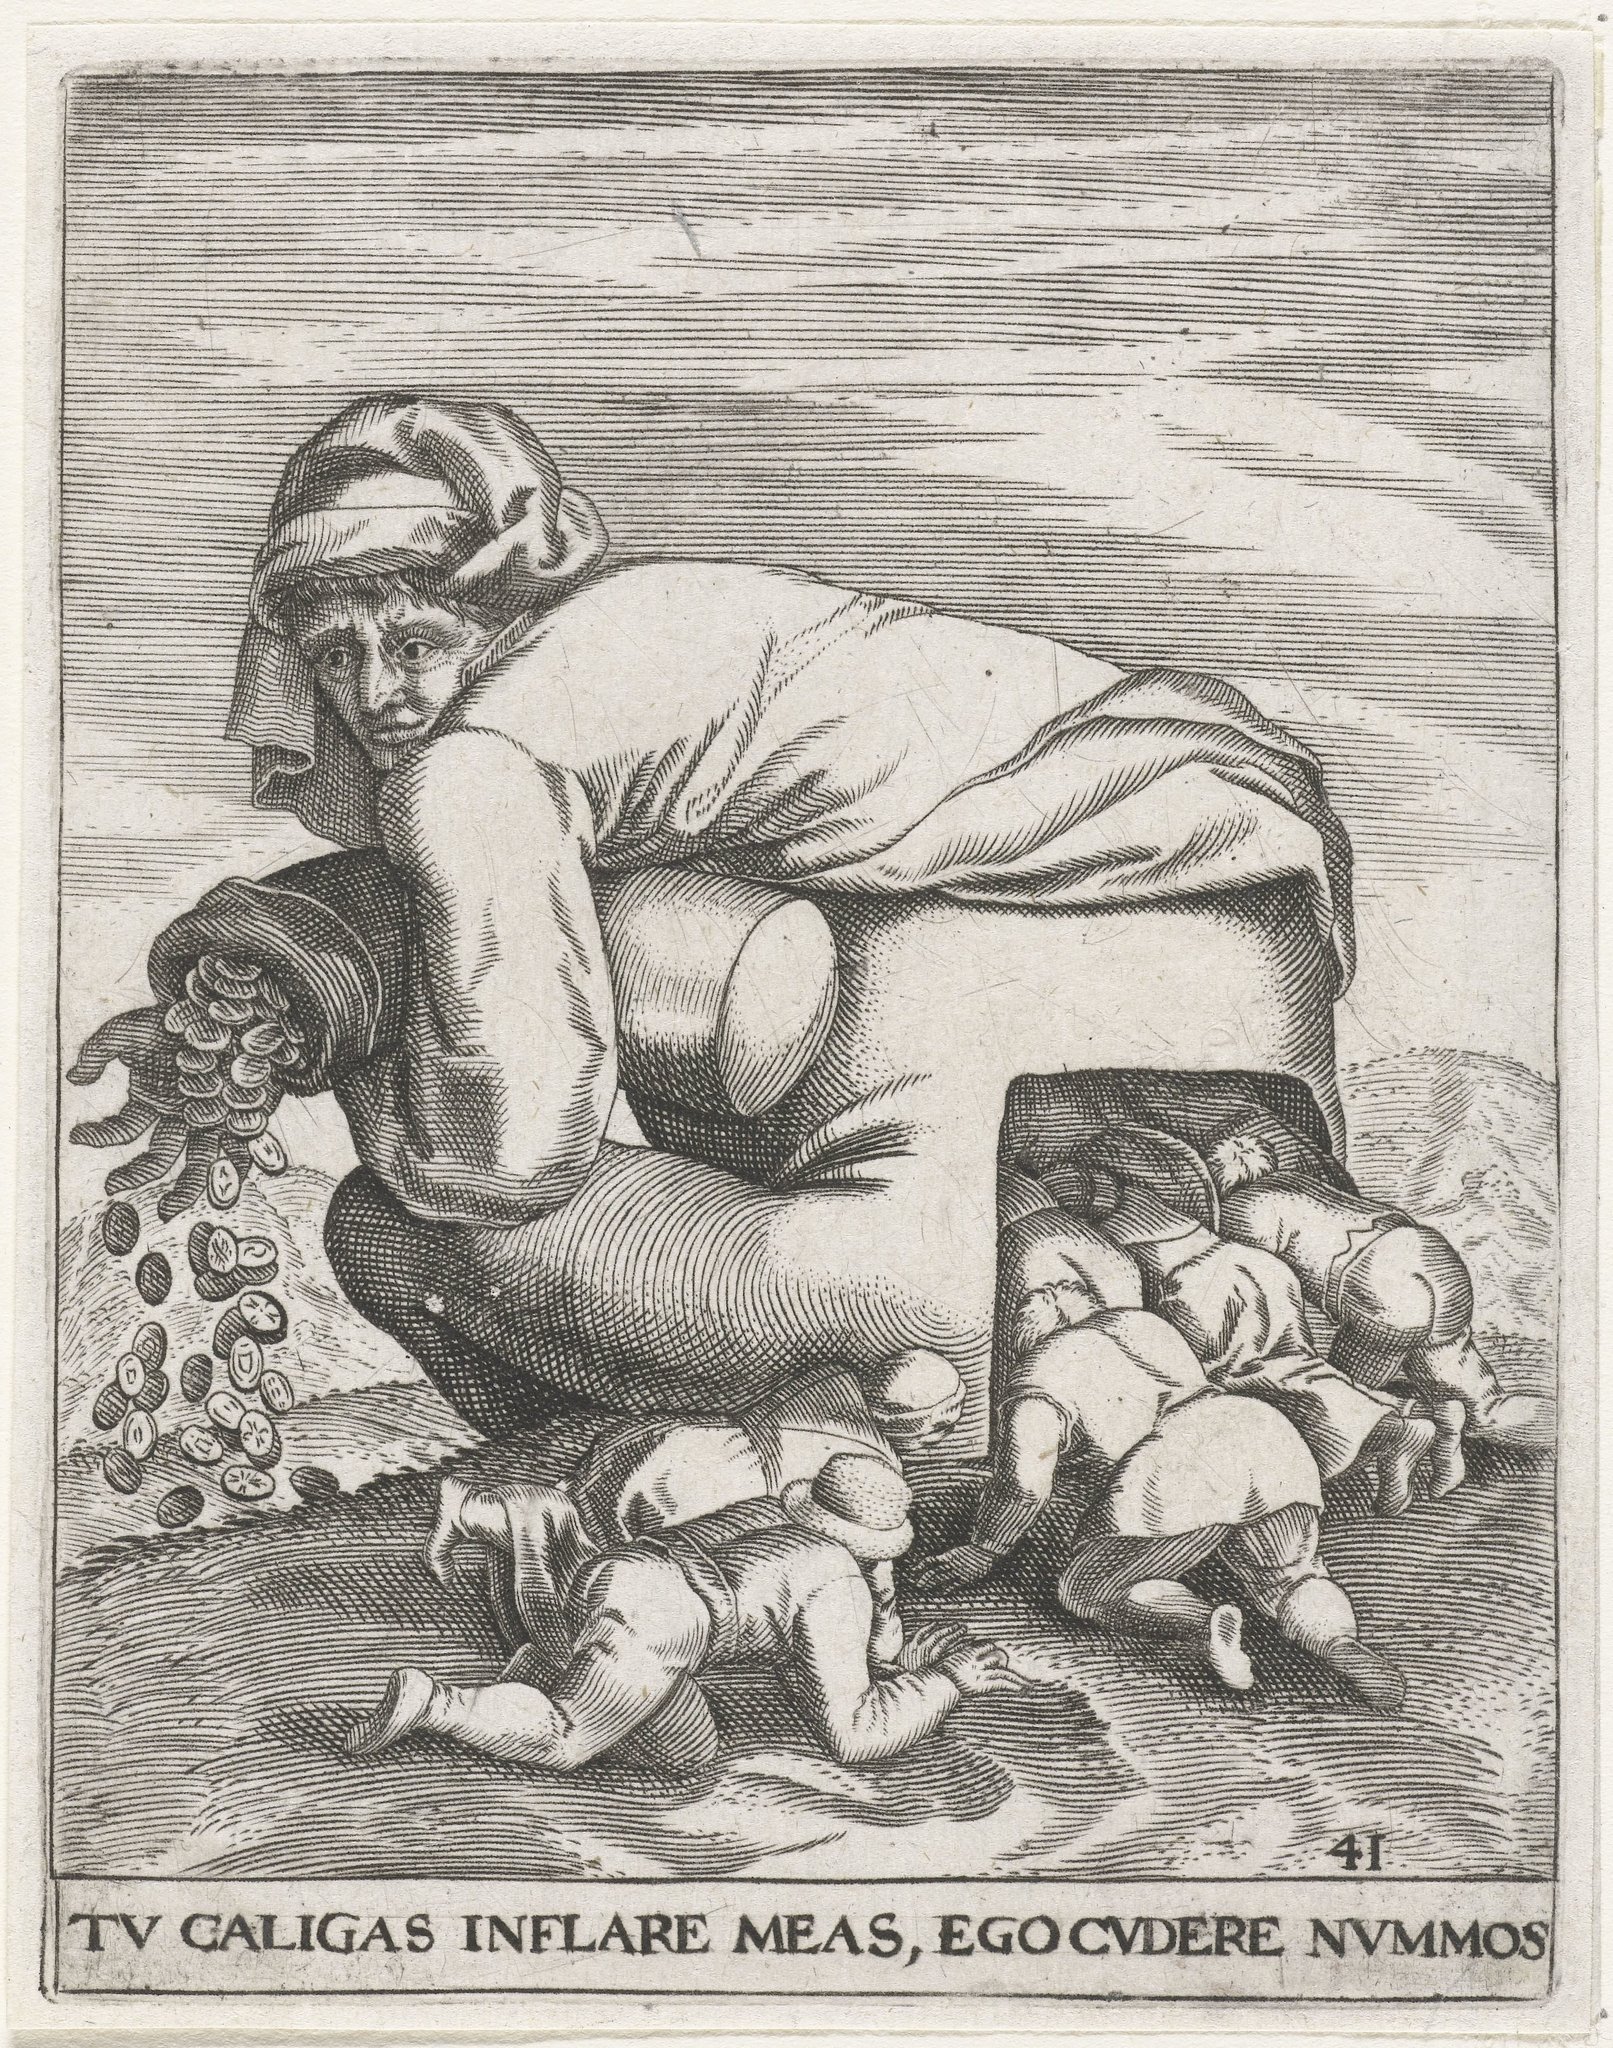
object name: book illustration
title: Emblemata Saecularia, 1596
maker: johann theodor de bry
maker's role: print maker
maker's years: 1561-1623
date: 1596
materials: paper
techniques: engraving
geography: frankfurt am main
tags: existence and modes of existence (+ emblematical representation of concept), servility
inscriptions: collector's mark: Lugt 240, inscription: ‘TU CALIGAS INFLARE MEAS, EGO CUDERE NUMMOS’, number: ‘41’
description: Voorgesteld is een kolossale hurkende persoon, door wiens "gat", dat letterlijk open staat, een stroom mensen naar binnen kruipt. De man strooit uit een grote zak geld op de grond. Naar een van de twaalf ronde spreekwoorden van Bruegel: Die ghelt te gheven heeft onder hooghe en slechte, En dat hij wat milt laet van sijnen schat, druijpen, Hy vrijcht Offitien en comt t'sijnen rechte, Want elck en weet niet hoe hem sal in t' gat cruijpen lezen we bij Bruegel. Spotprent op de vleierij.